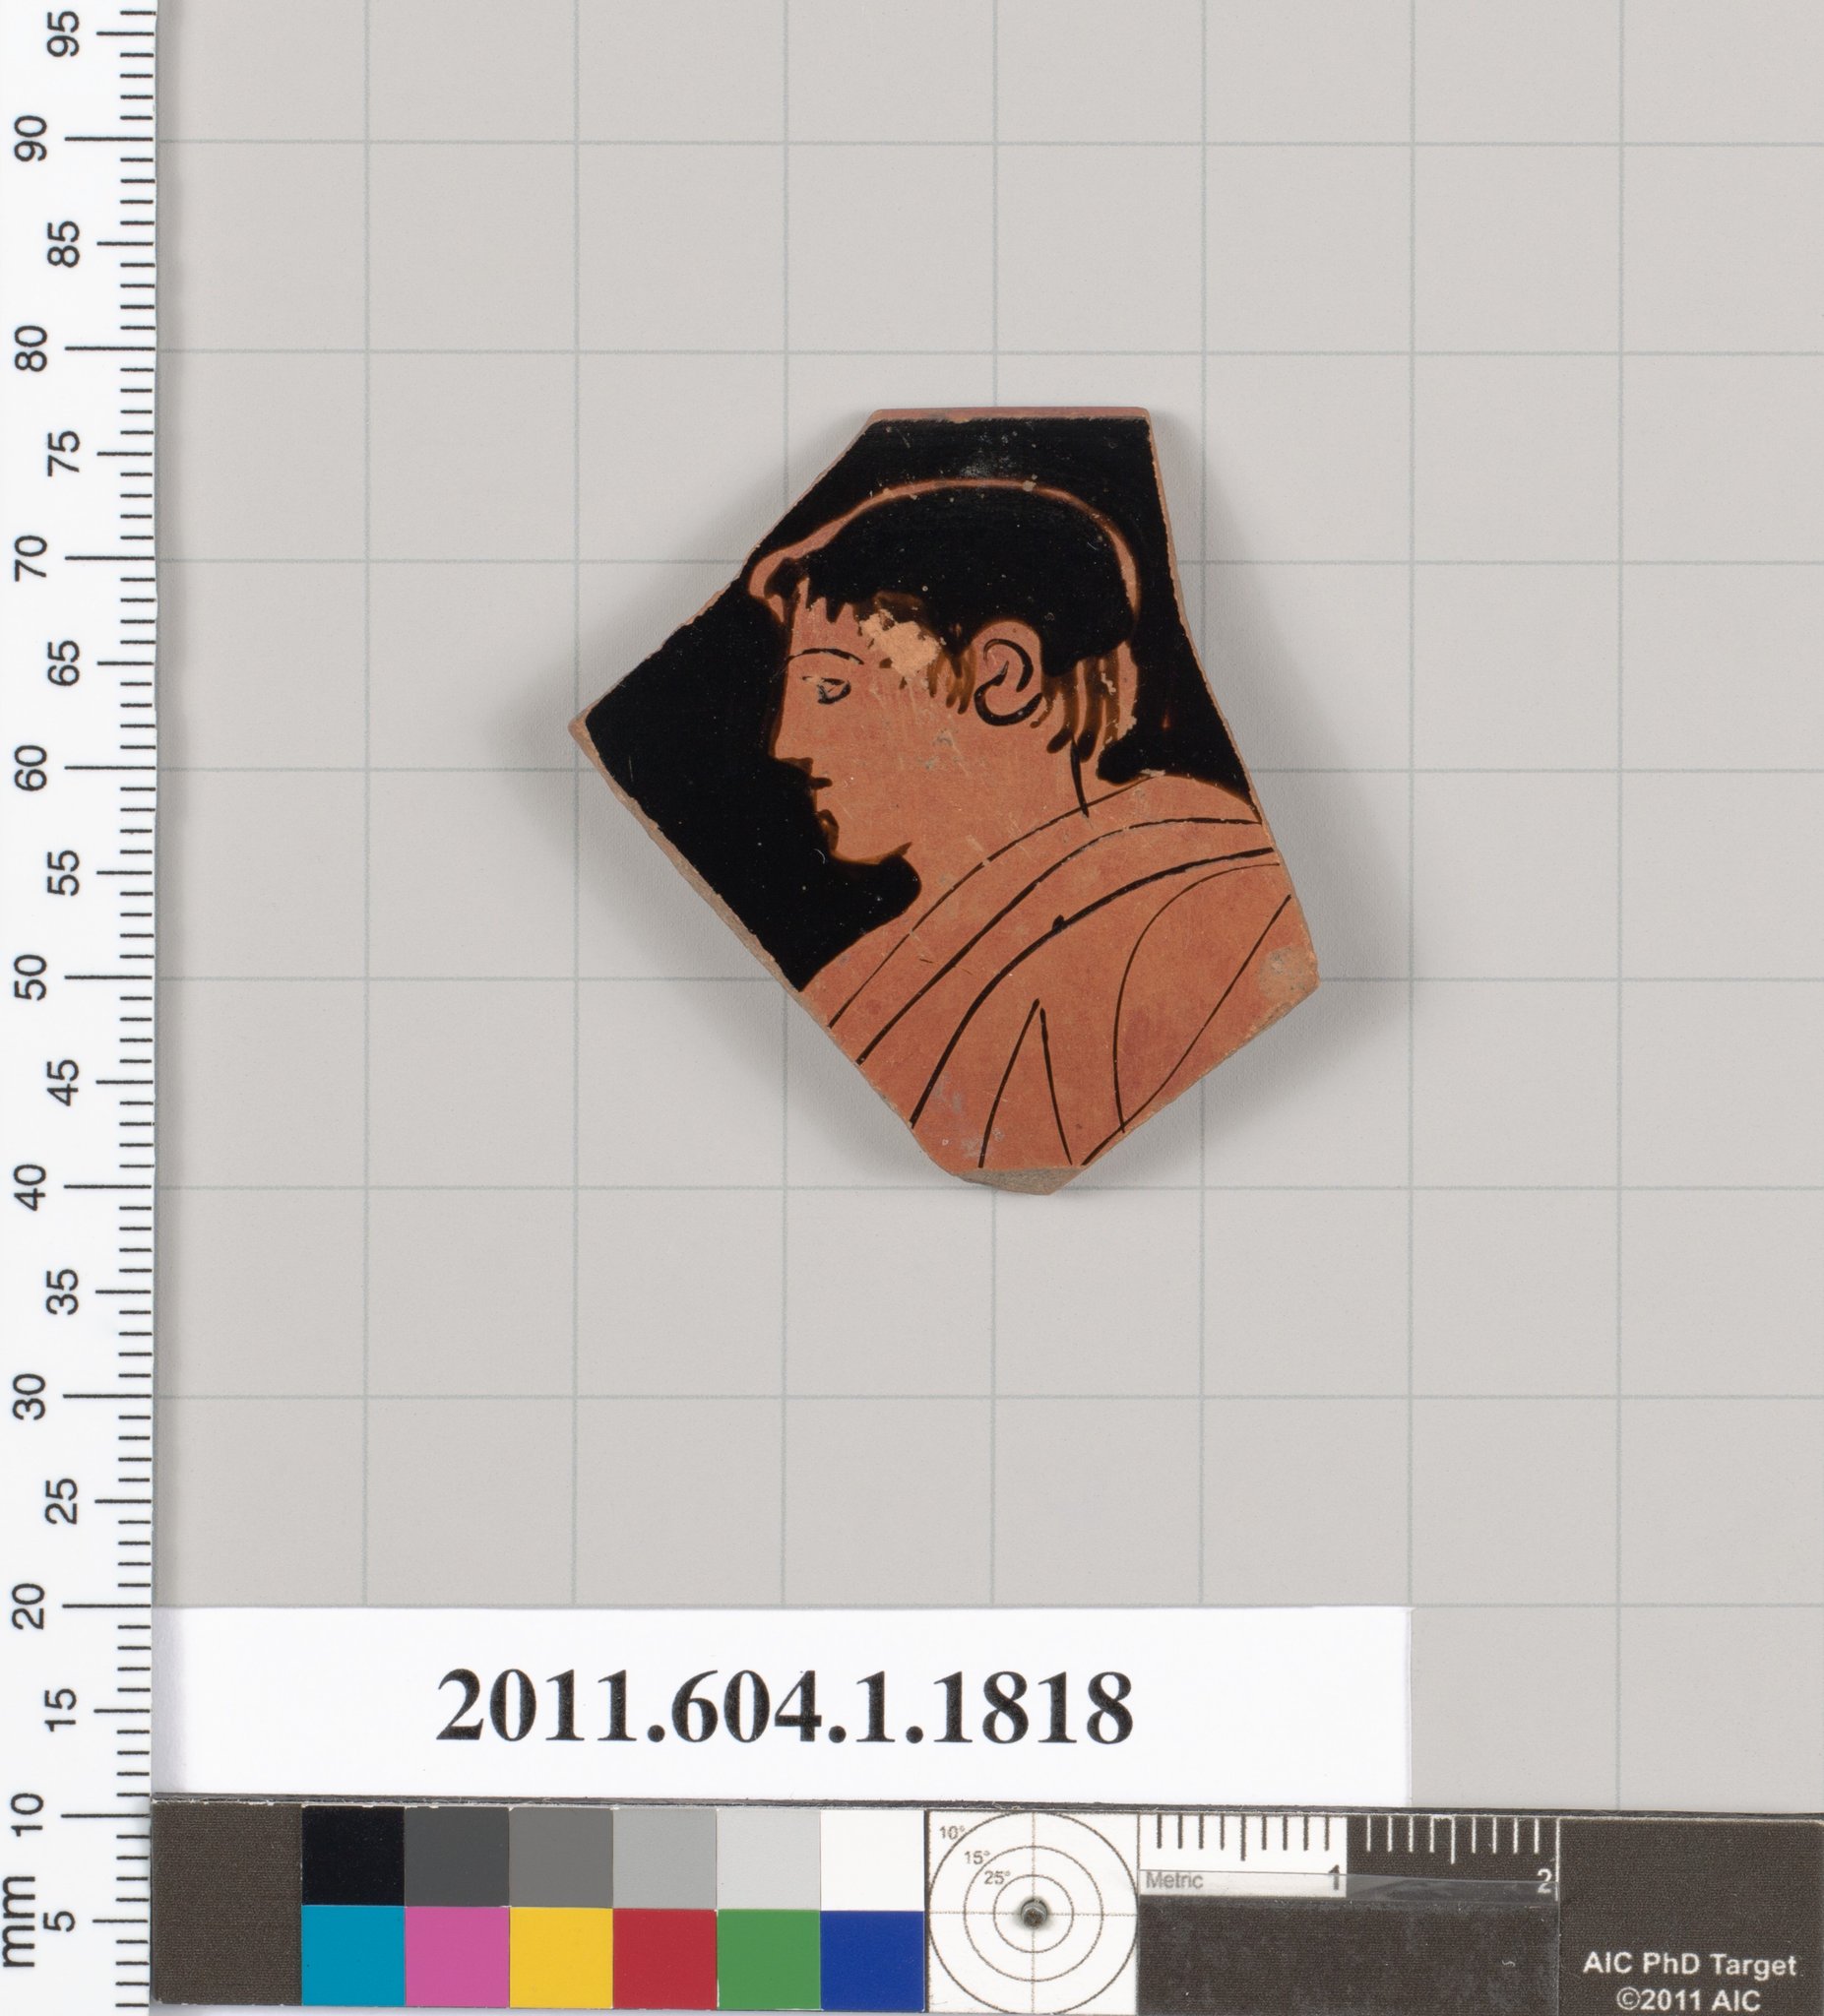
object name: kylix fragment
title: Terracotta rim fragment of a kylix (drinking cup)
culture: greek, attic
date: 475-451 BCE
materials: terracotta